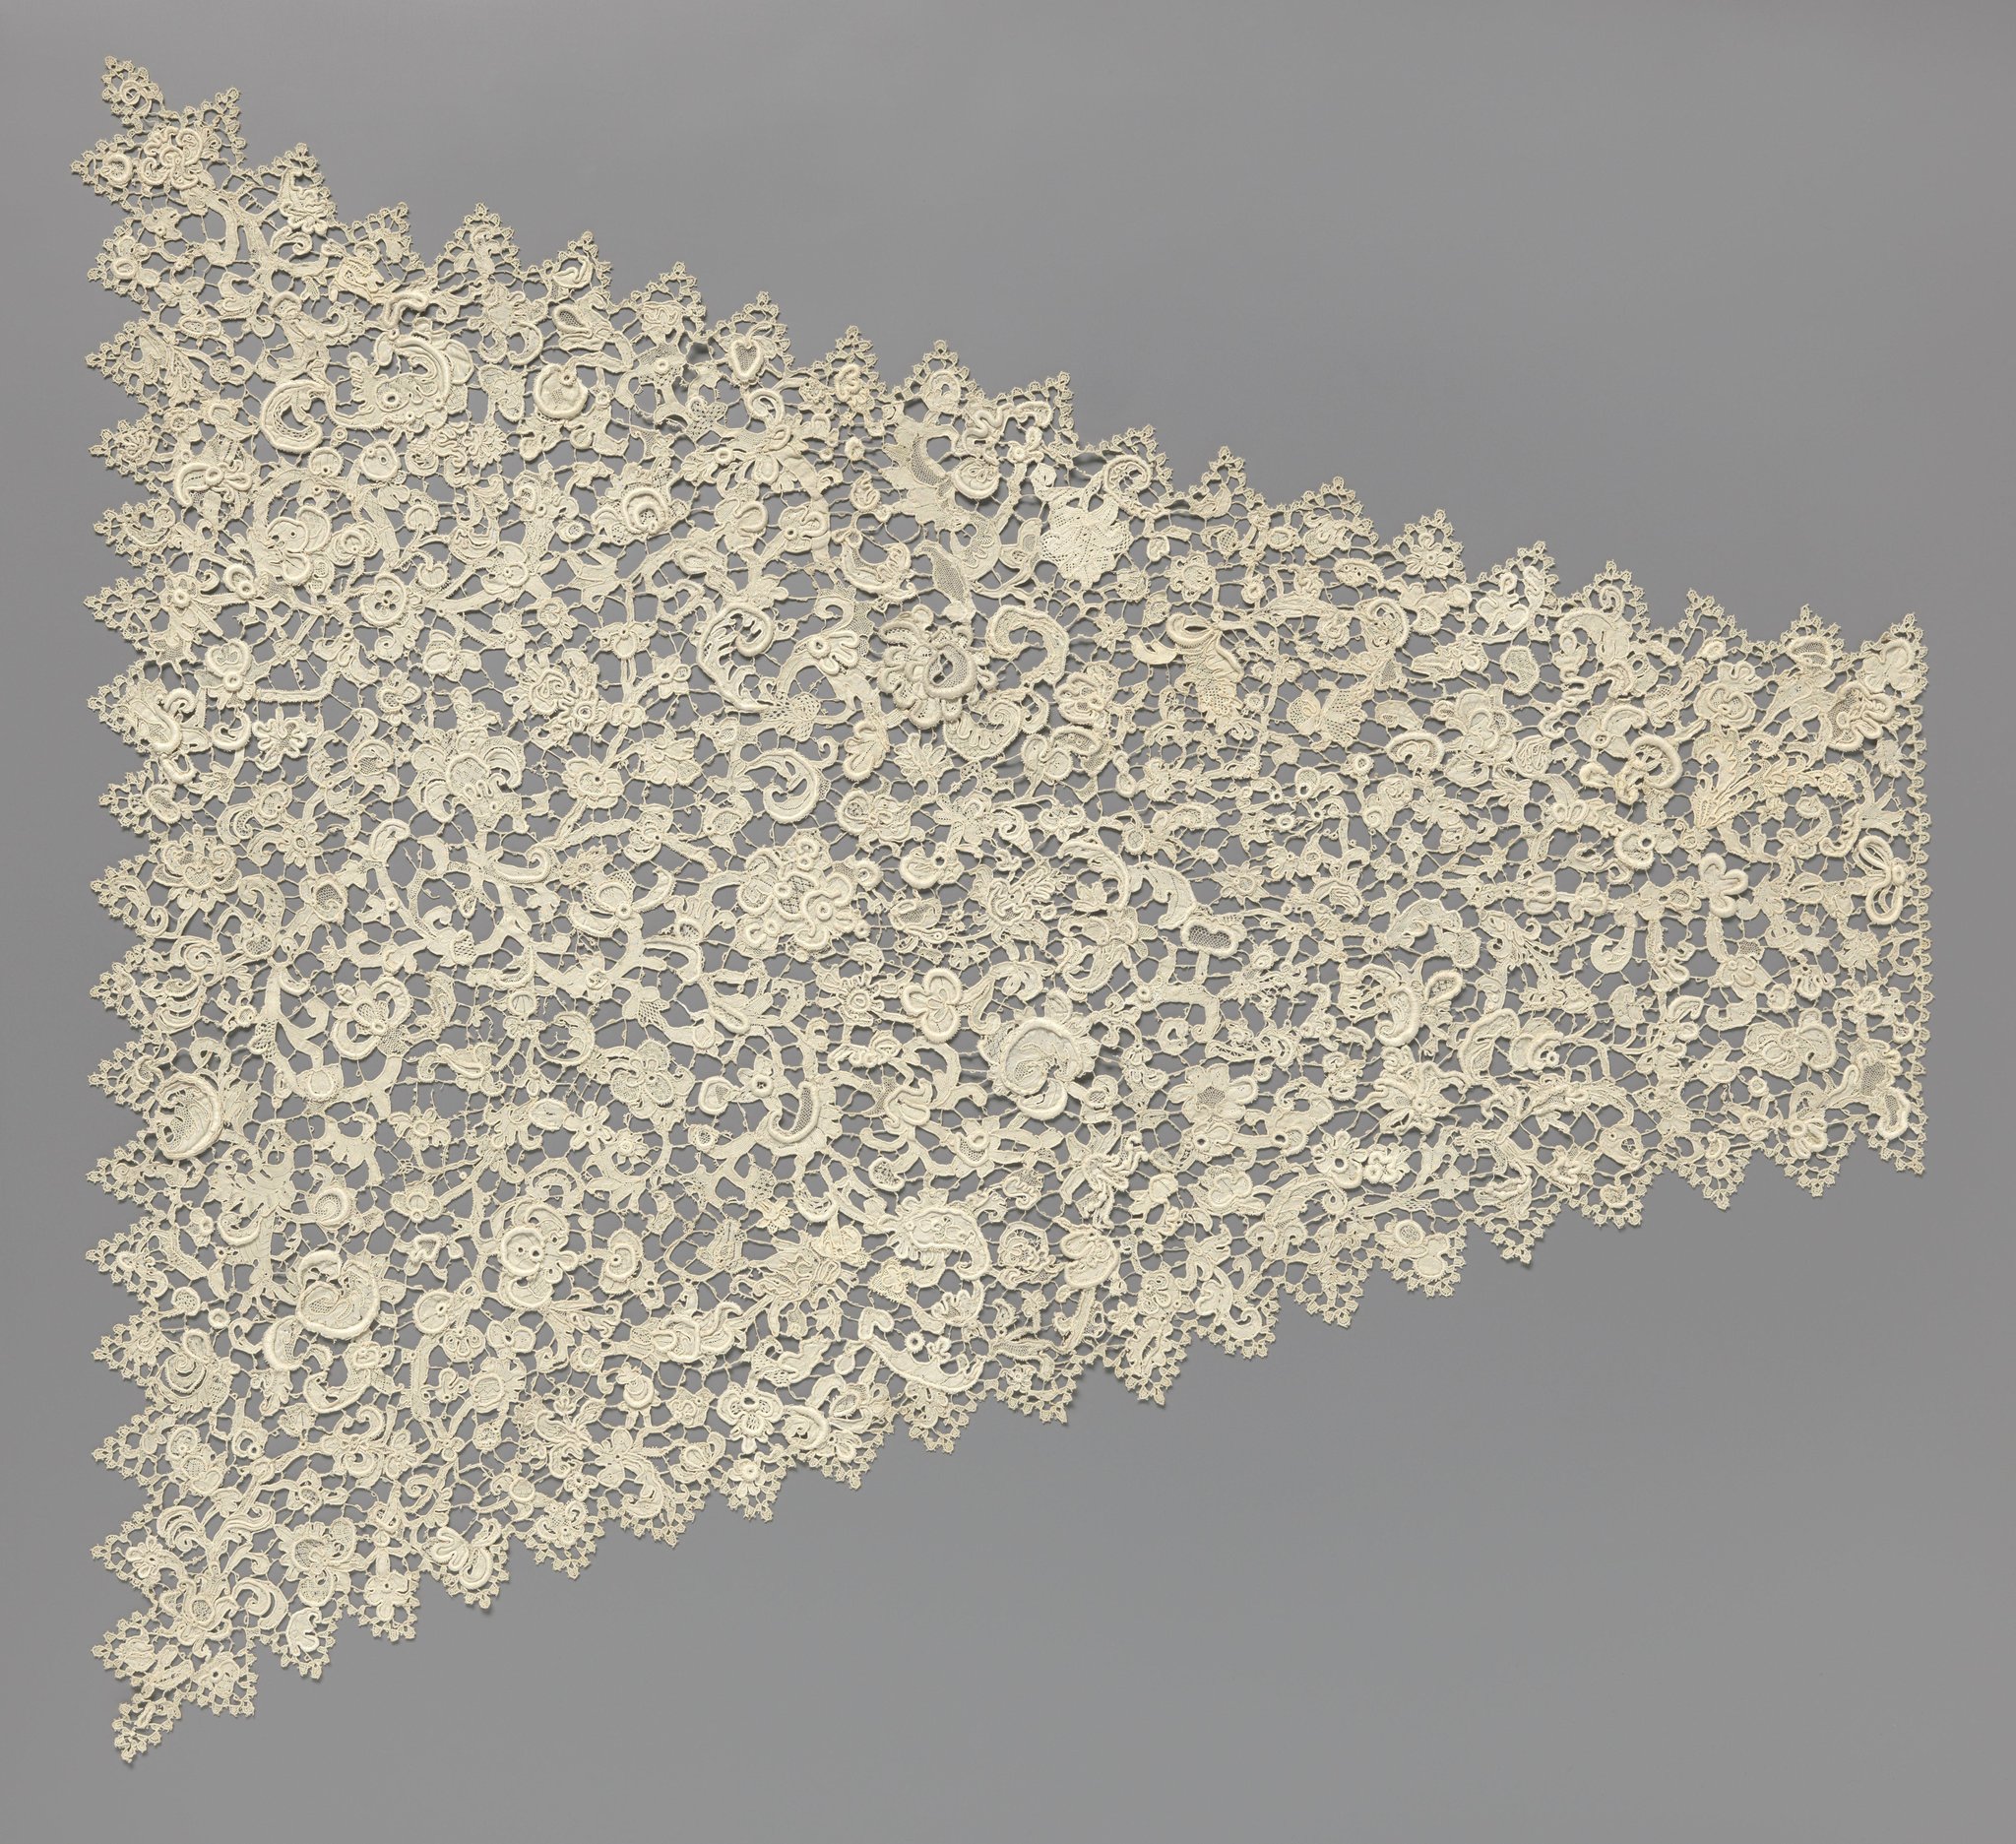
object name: clothing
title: Tablier of sierschort, omstreeks 1900 samengesteld uit 17de eeuwse naaldkantornamenten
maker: Anonymous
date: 1660-1674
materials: linen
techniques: embroidery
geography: venice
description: Tablier of sierschort van naturelkleurige naaldkant: Venetiaanse reliëfkant. Lang trapeziumvormig model. Het is omstreeks 1900 samengesteld uit 17e-eeuwse motieven, gemaakt van Venetiaanse naaldkant. Aan het schort zijn omstreeks 1900 ook nieuwe motieven en andere elementen toegevoegd, waaronder siervullingen en (nieuwe) gepicoteerde spijlen waarmee de motieven met elkaar verbonden zijn. De kleine geschulpte rand om het schort heen is ook 19e-eeuws.